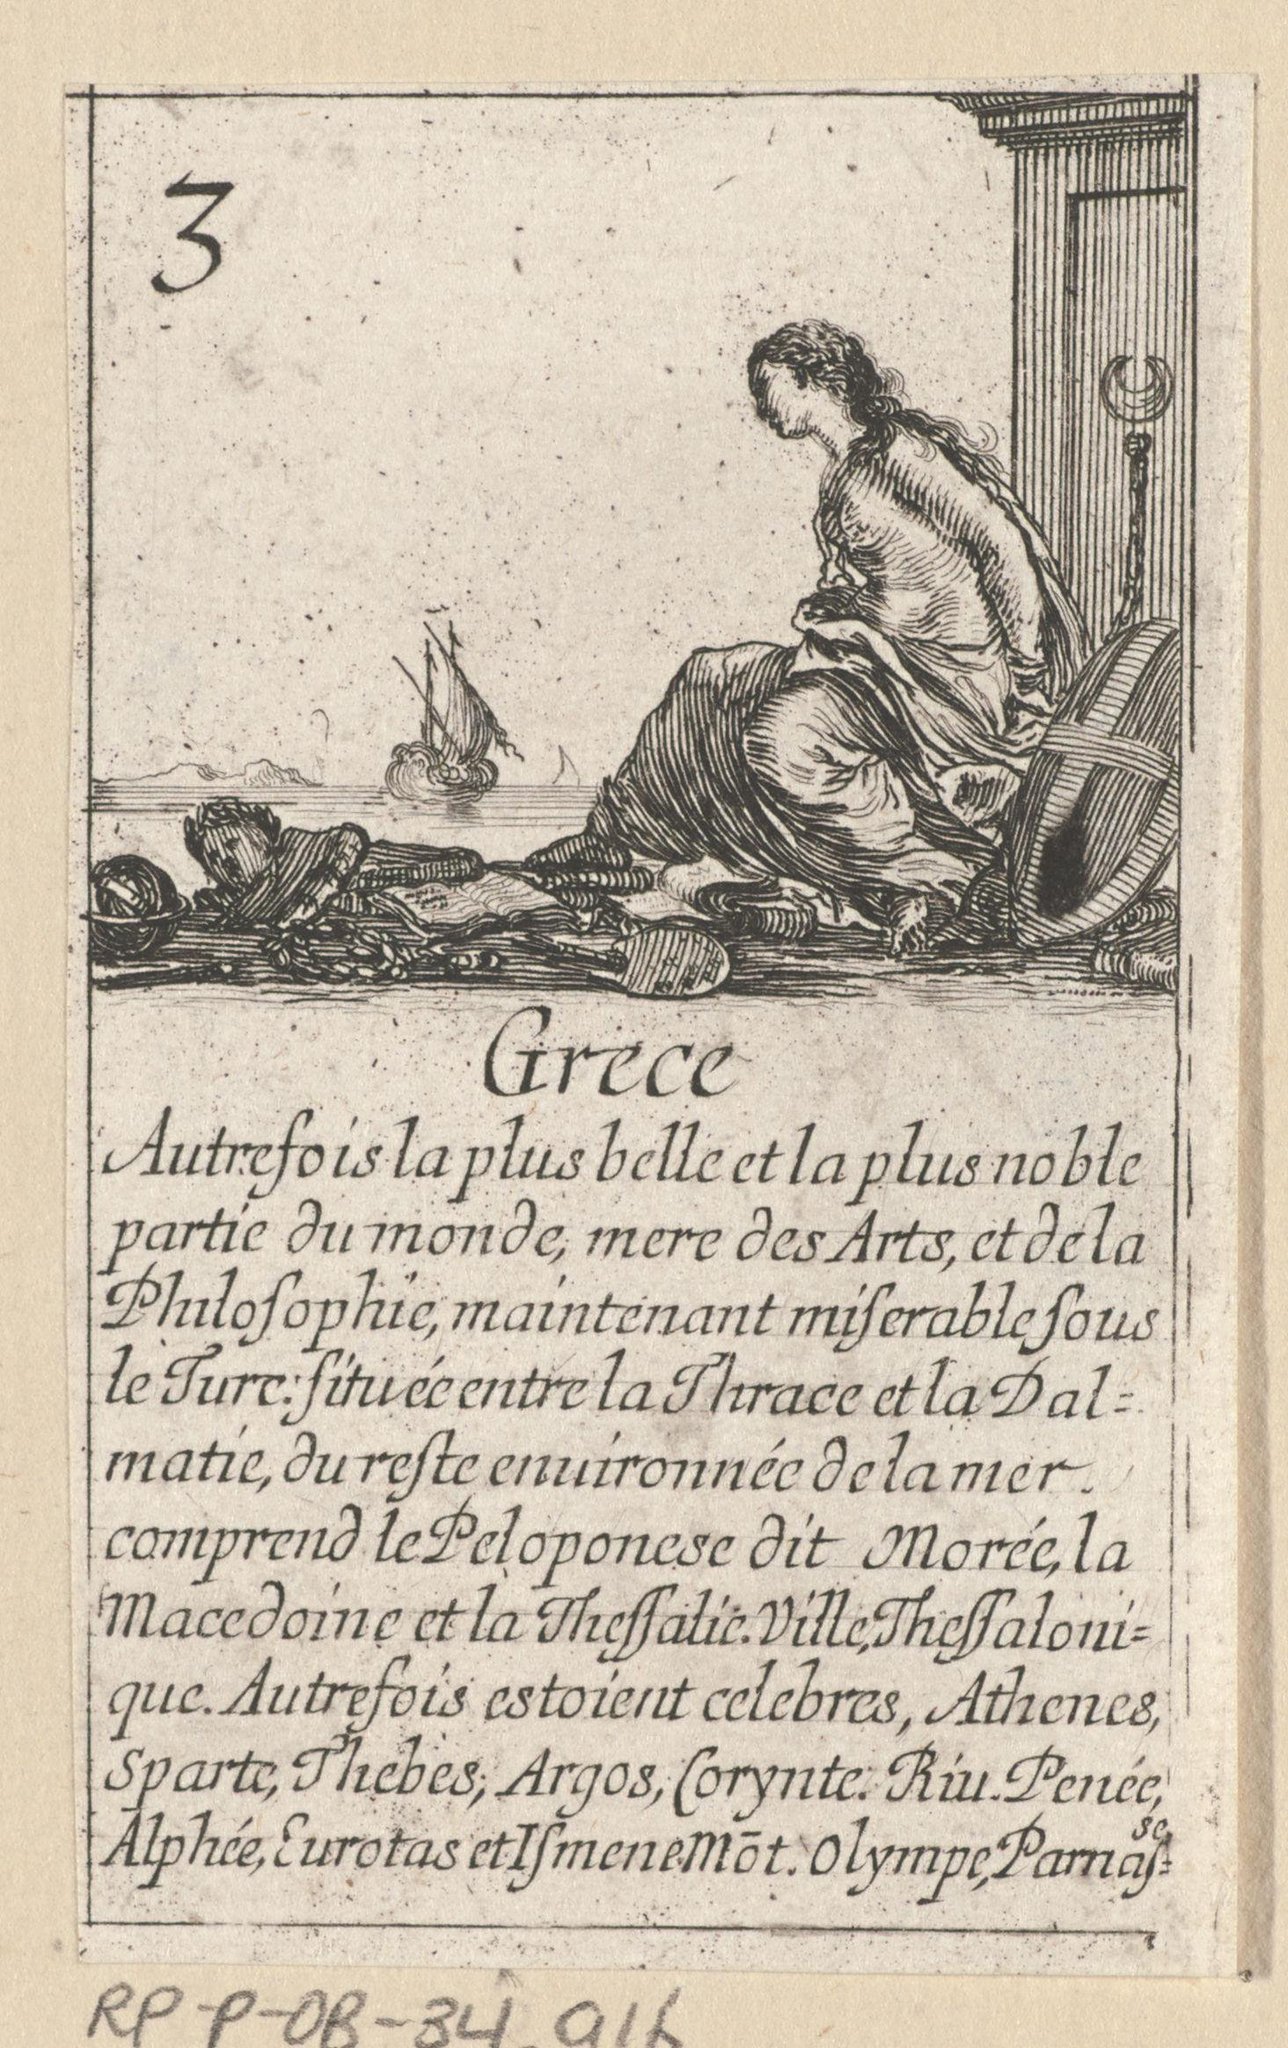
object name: print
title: Jeu de la géographie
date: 1620-1664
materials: paper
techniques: etching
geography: paris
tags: europeans, sitting figure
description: Deze prent maakt deel uit van een kaartspel met 52 kaarten met voorstellingen van vrouwen uit landen over de hele wereld. De serie is uitgedacht door Jean Desmarests de Saint-Sorlin in opdracht van Kardinaal Mazarin. Het kaartspel werd gemaakt voor de jonge Lodewijk XIV, samen met het Jeu des Fables, Jeu des Reynes Renommées en Jeu des Rois de France.